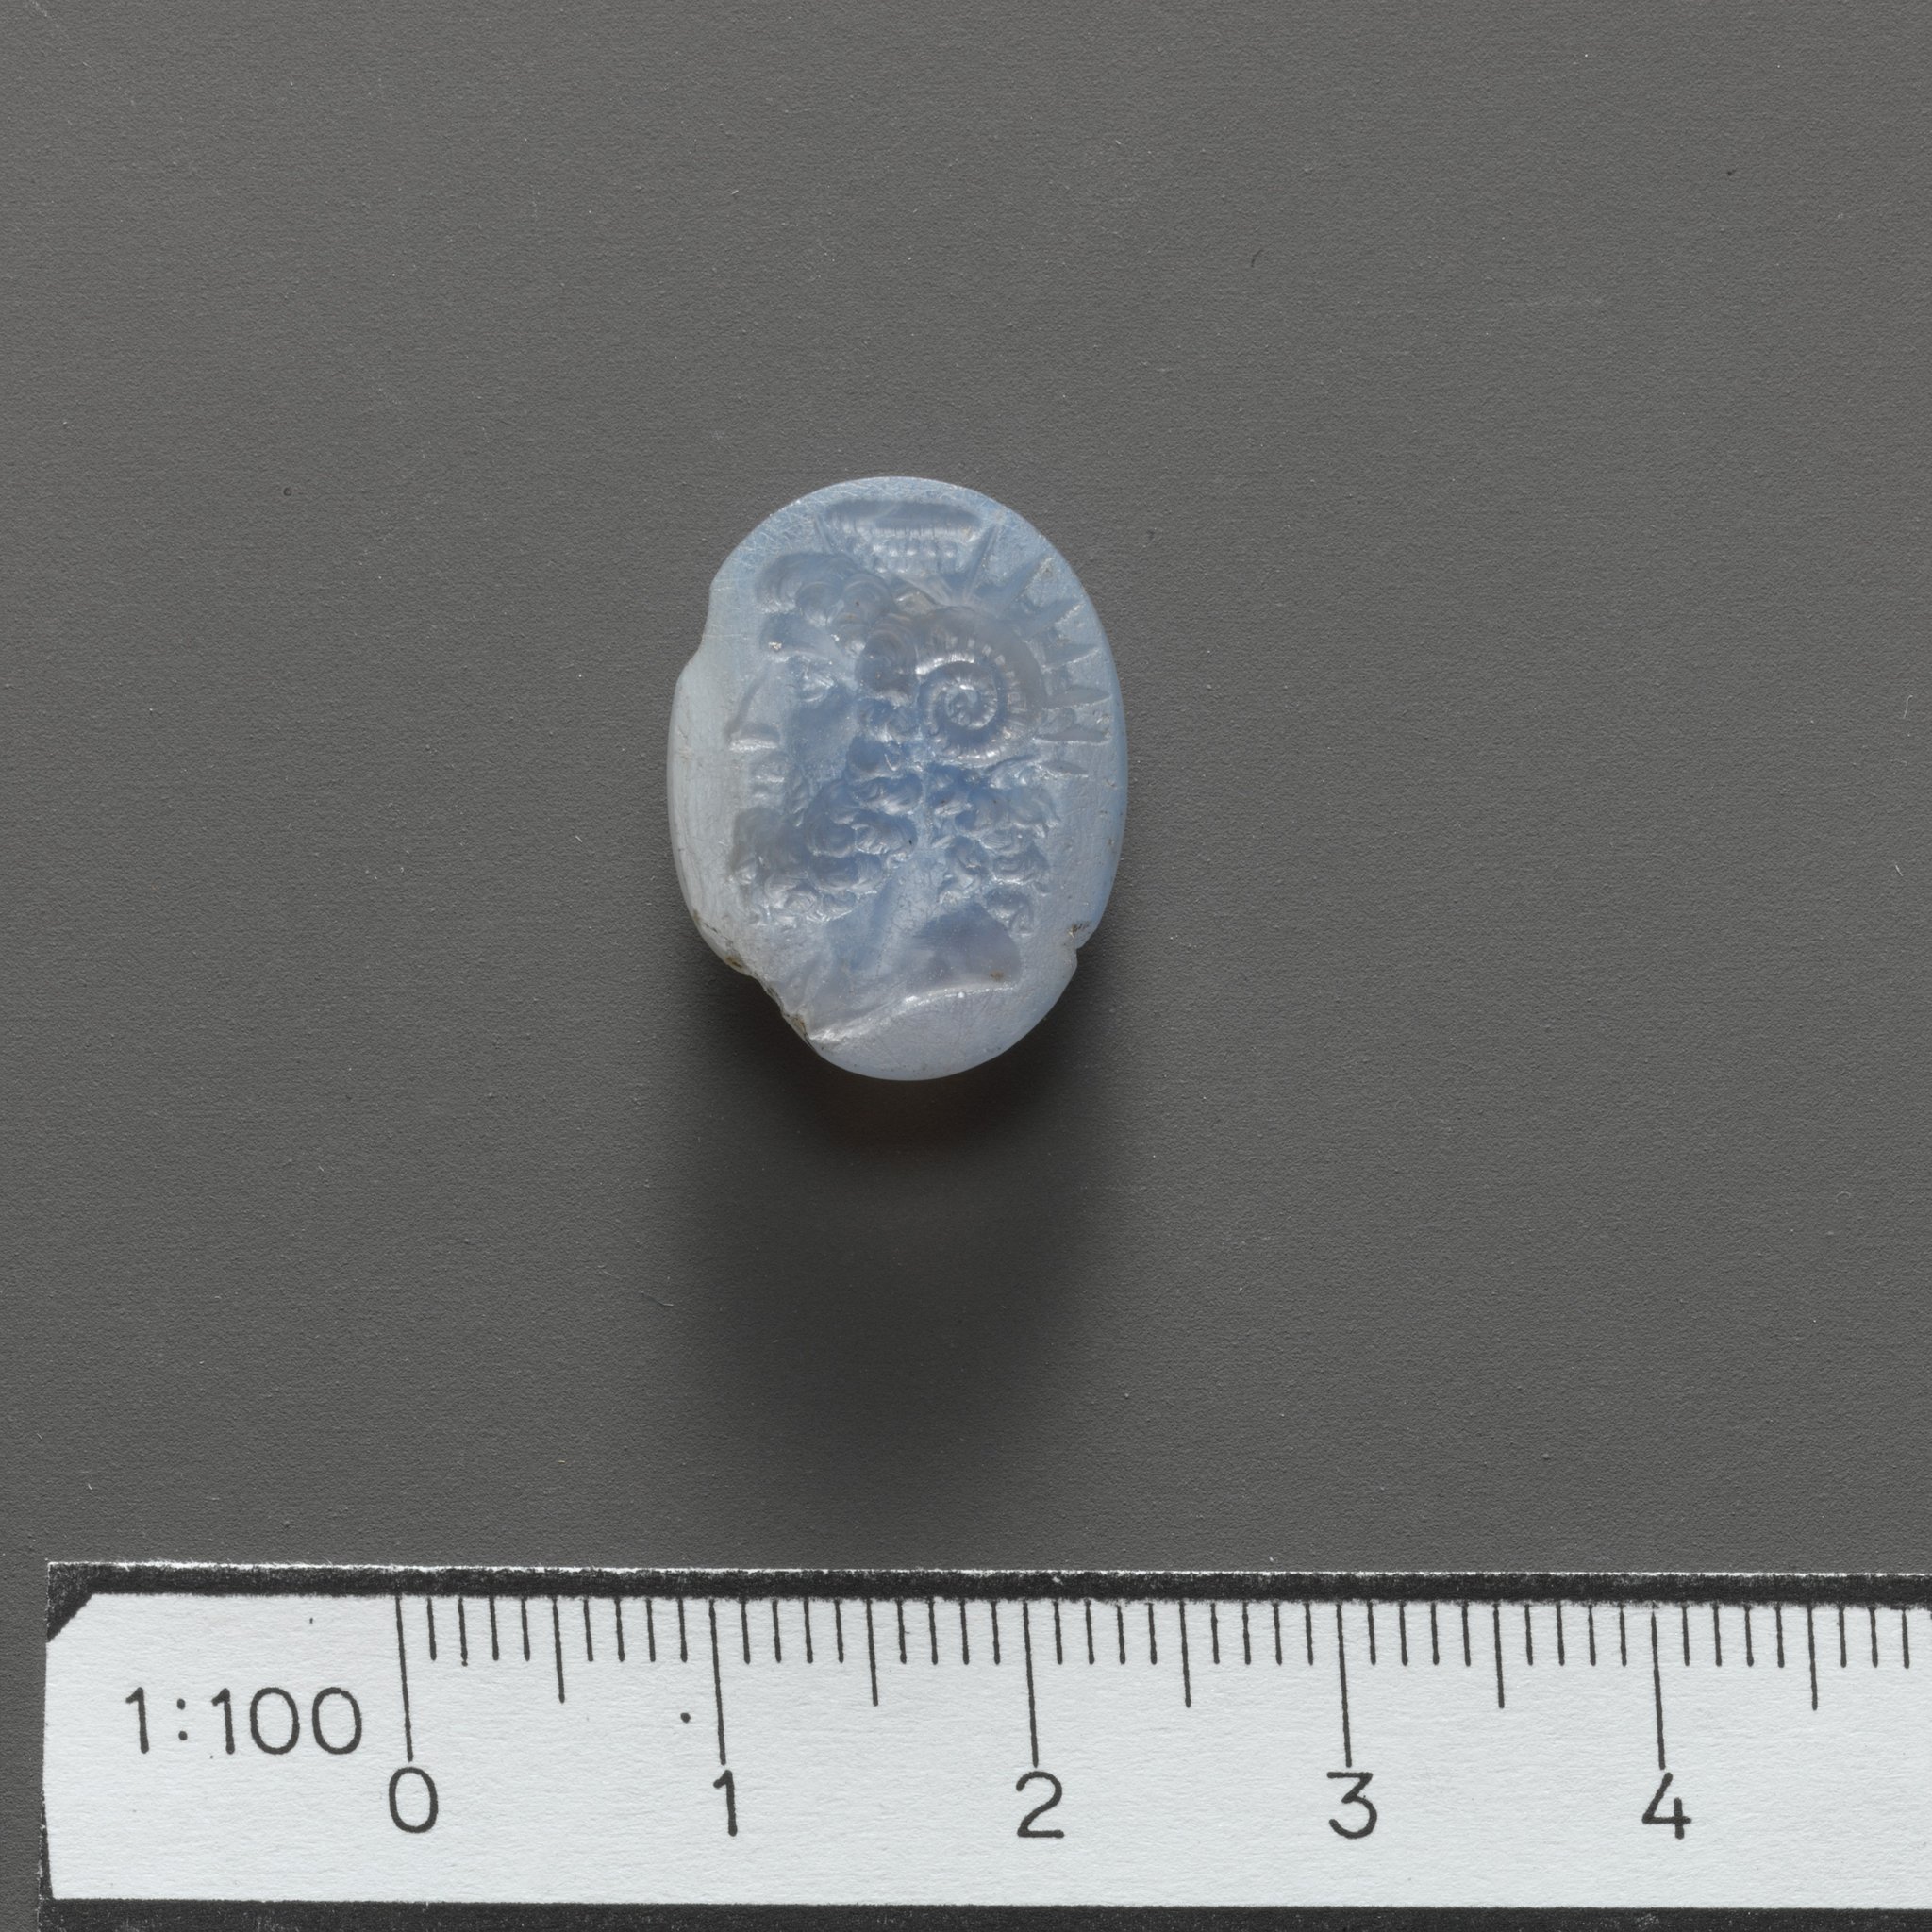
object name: intaglio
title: Chalcedony intaglio: Head of Jupiter Ammon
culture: roman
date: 1-300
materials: stone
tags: heads,jupiter